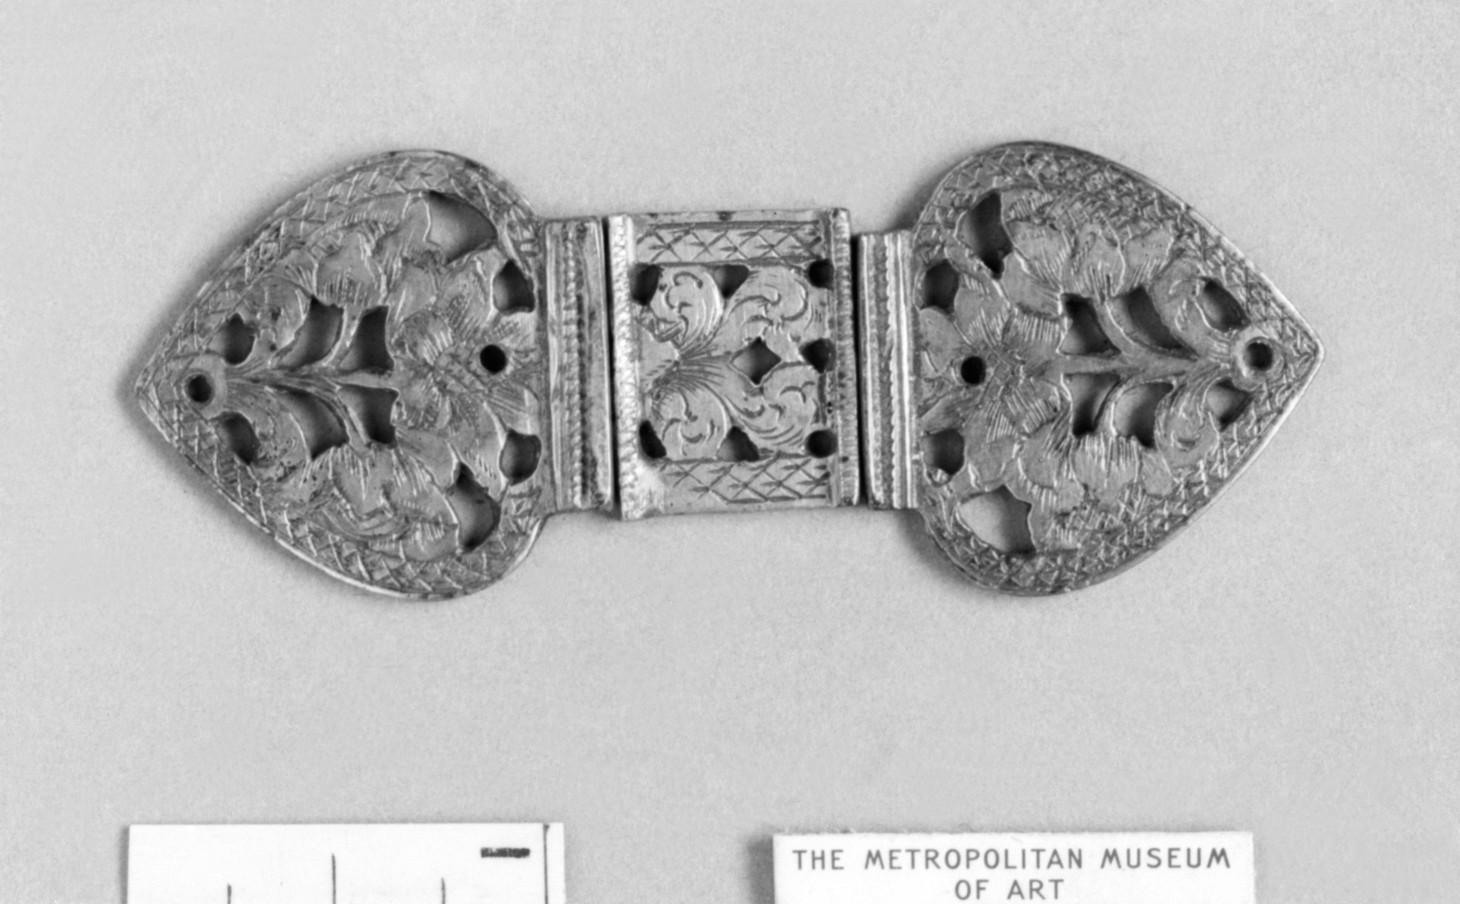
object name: book clasp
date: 1601-1700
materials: silver gilt